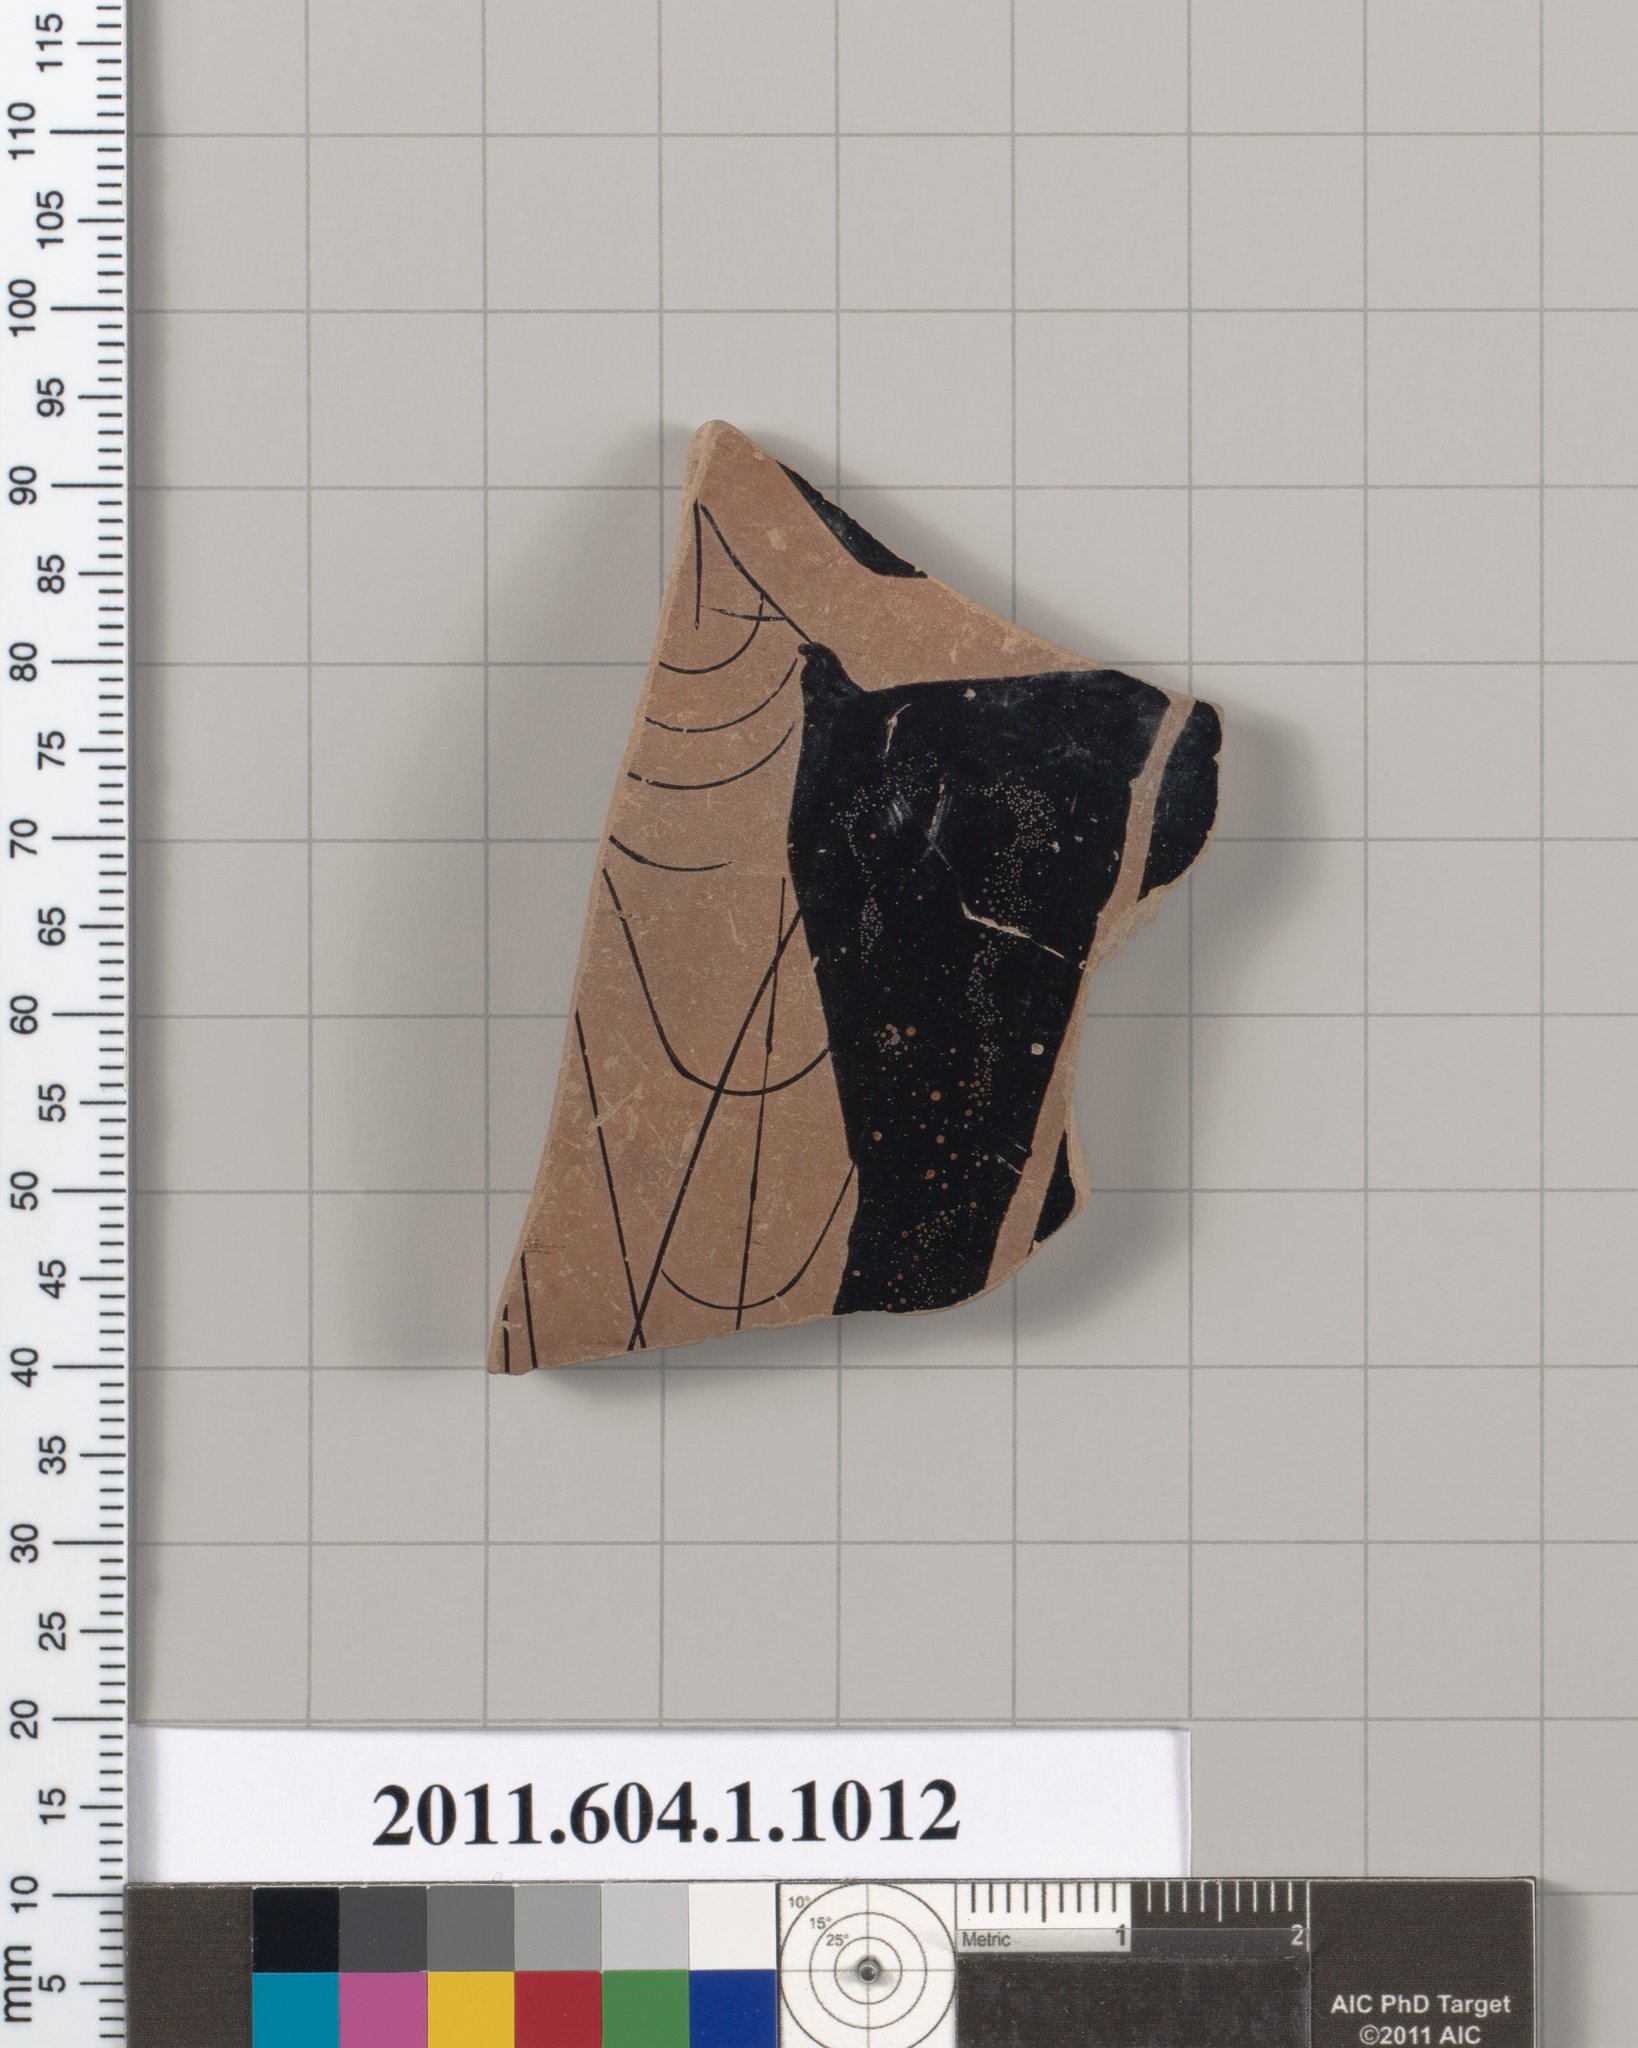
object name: kylix fragment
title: Terracotta fragment of a kylix (drinking cup)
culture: greek, attic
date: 475-451 BCE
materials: terracotta